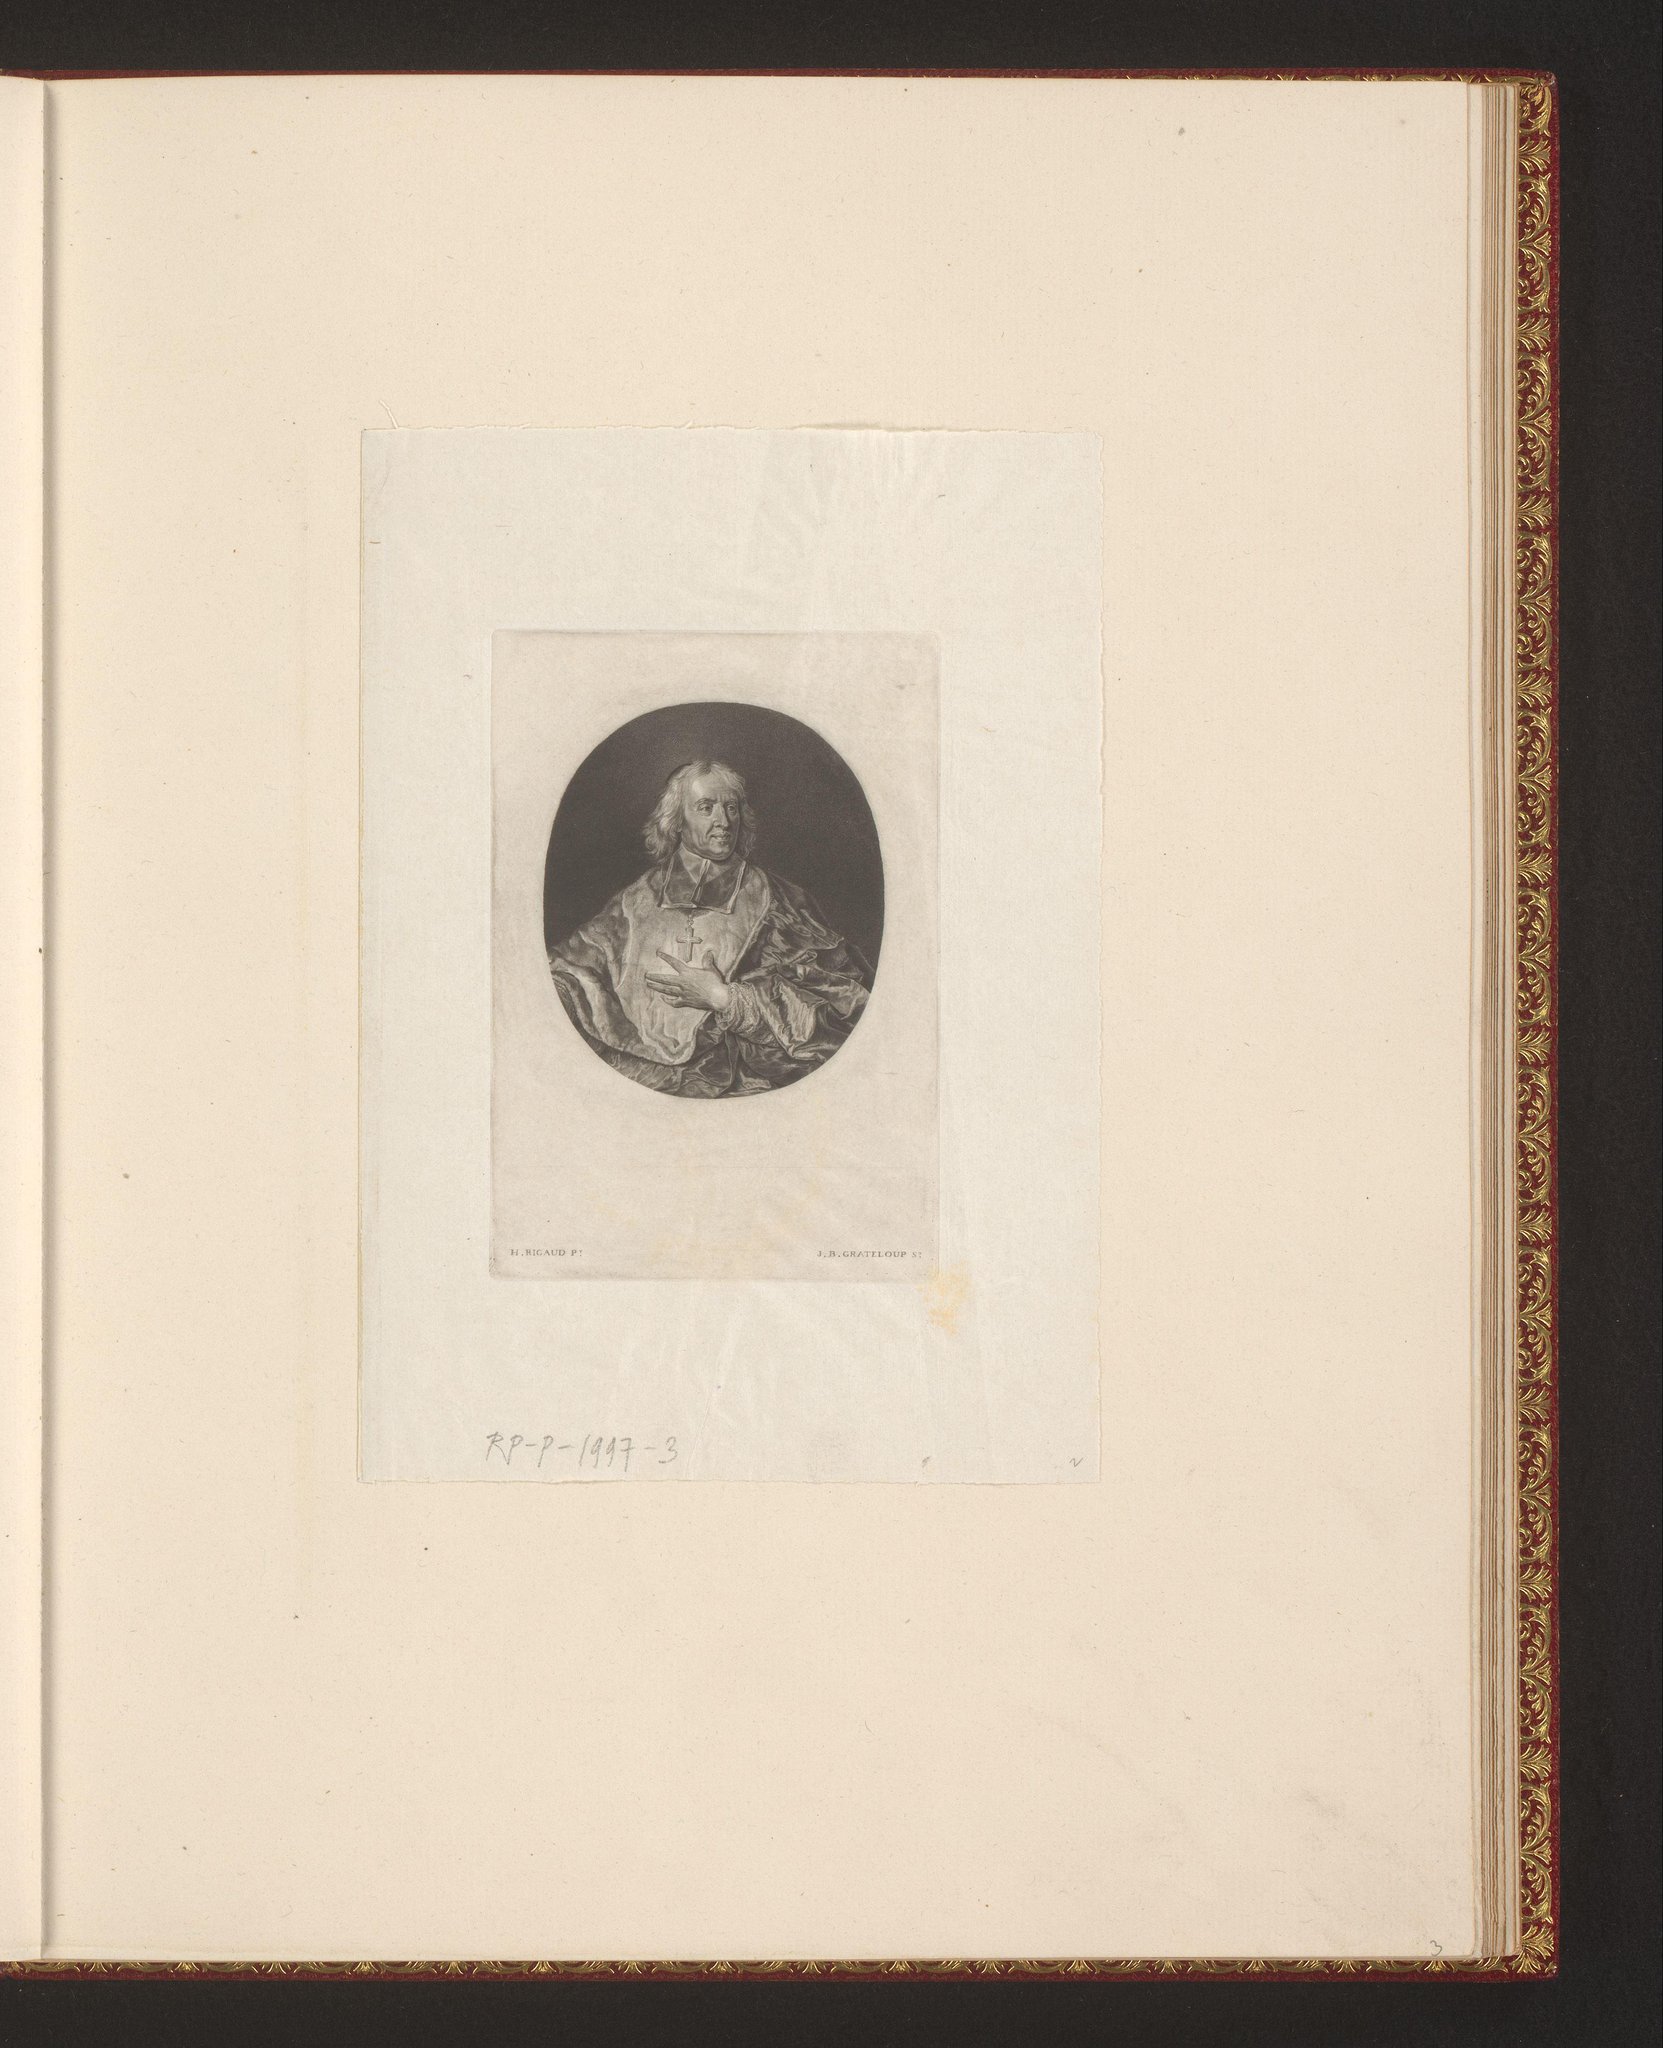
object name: album leaf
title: Portret van Jacques Bénigne Bossuet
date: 1769-1770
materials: paper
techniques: aquatint, etching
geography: france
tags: paris, archbishop, bishop, etc. (roman catholic), theologian, historical persons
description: Jean-Baptiste de Grateloup gebruikte een geheim proces bij het maken van zijn prenten, lijkend op aquatint. Zijn neef Jean-Pierre Sylvestre de Grateloup heeft ook op deze manier gewerkt.